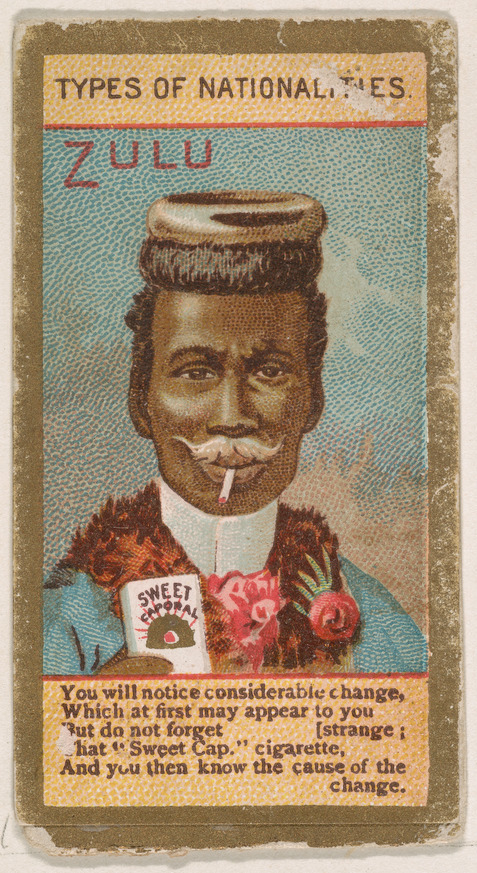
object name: print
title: Zulu, from Types of Nationalities (N240) issued by Kinney Bros.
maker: kinney brothers tobacco company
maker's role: publisher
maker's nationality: american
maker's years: 1869-2011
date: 1890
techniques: color lithograph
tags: men,smoking